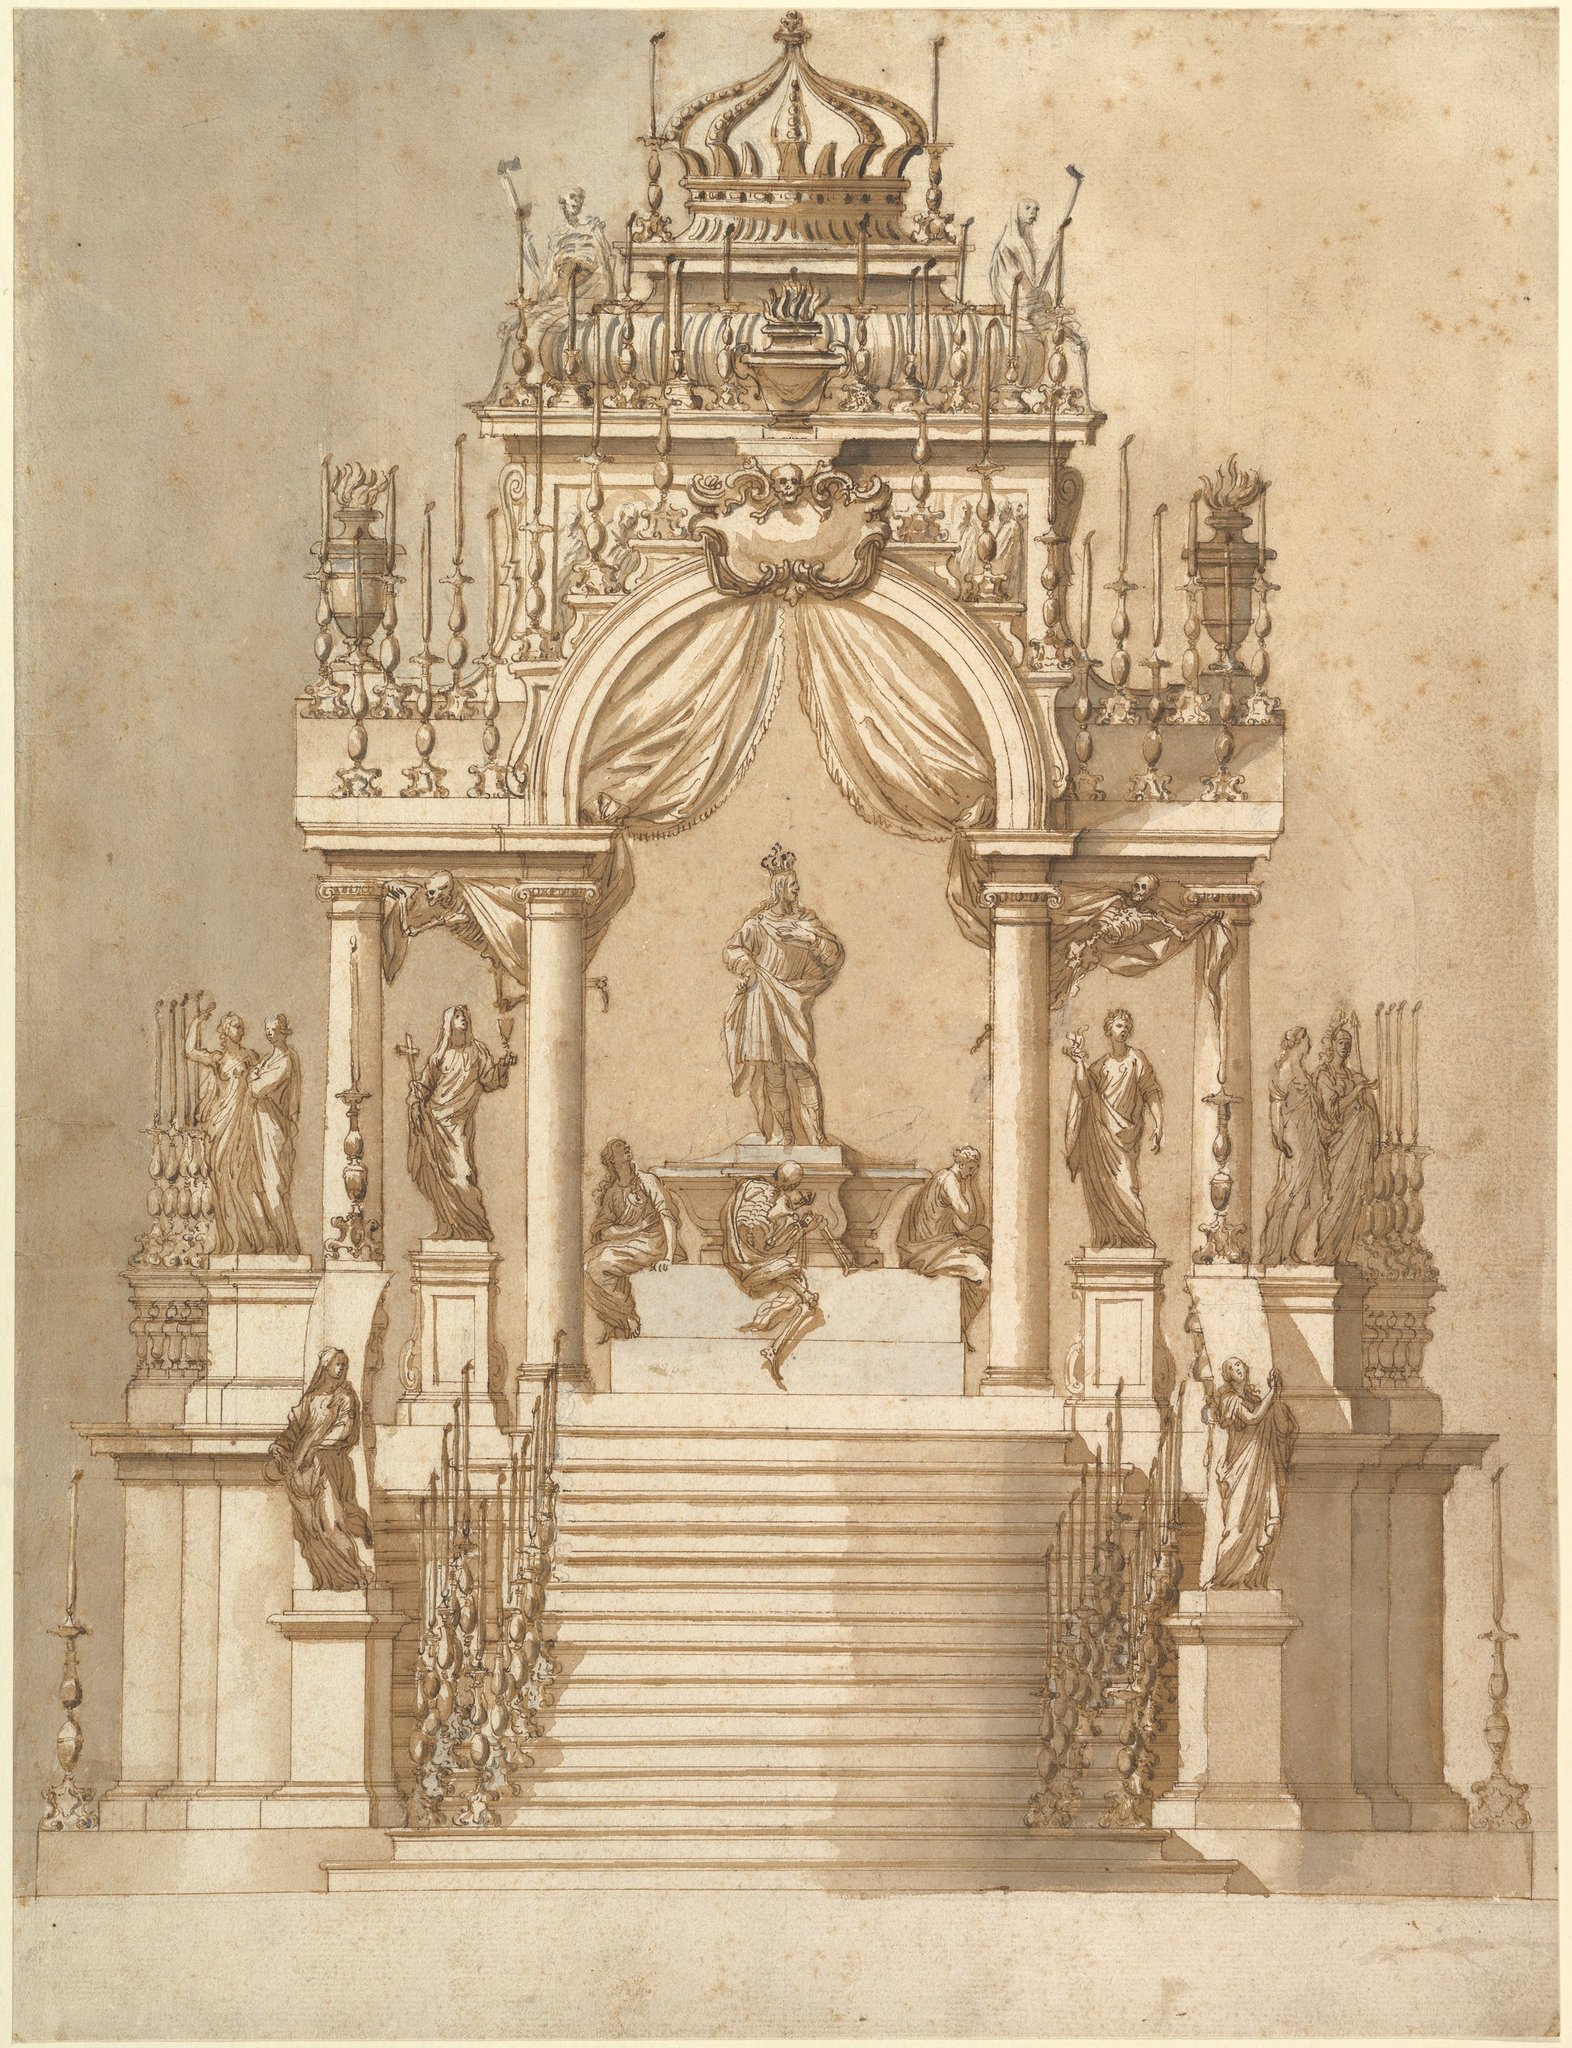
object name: drawing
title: Design for a Catafalque for King Philip IV of Spain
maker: anonymous, italian, 17th century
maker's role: artist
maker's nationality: italian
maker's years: 1600-1700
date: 1601-1700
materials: graphite, ink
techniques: brush, highlighting, pen, wash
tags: architecture,columns,stairs